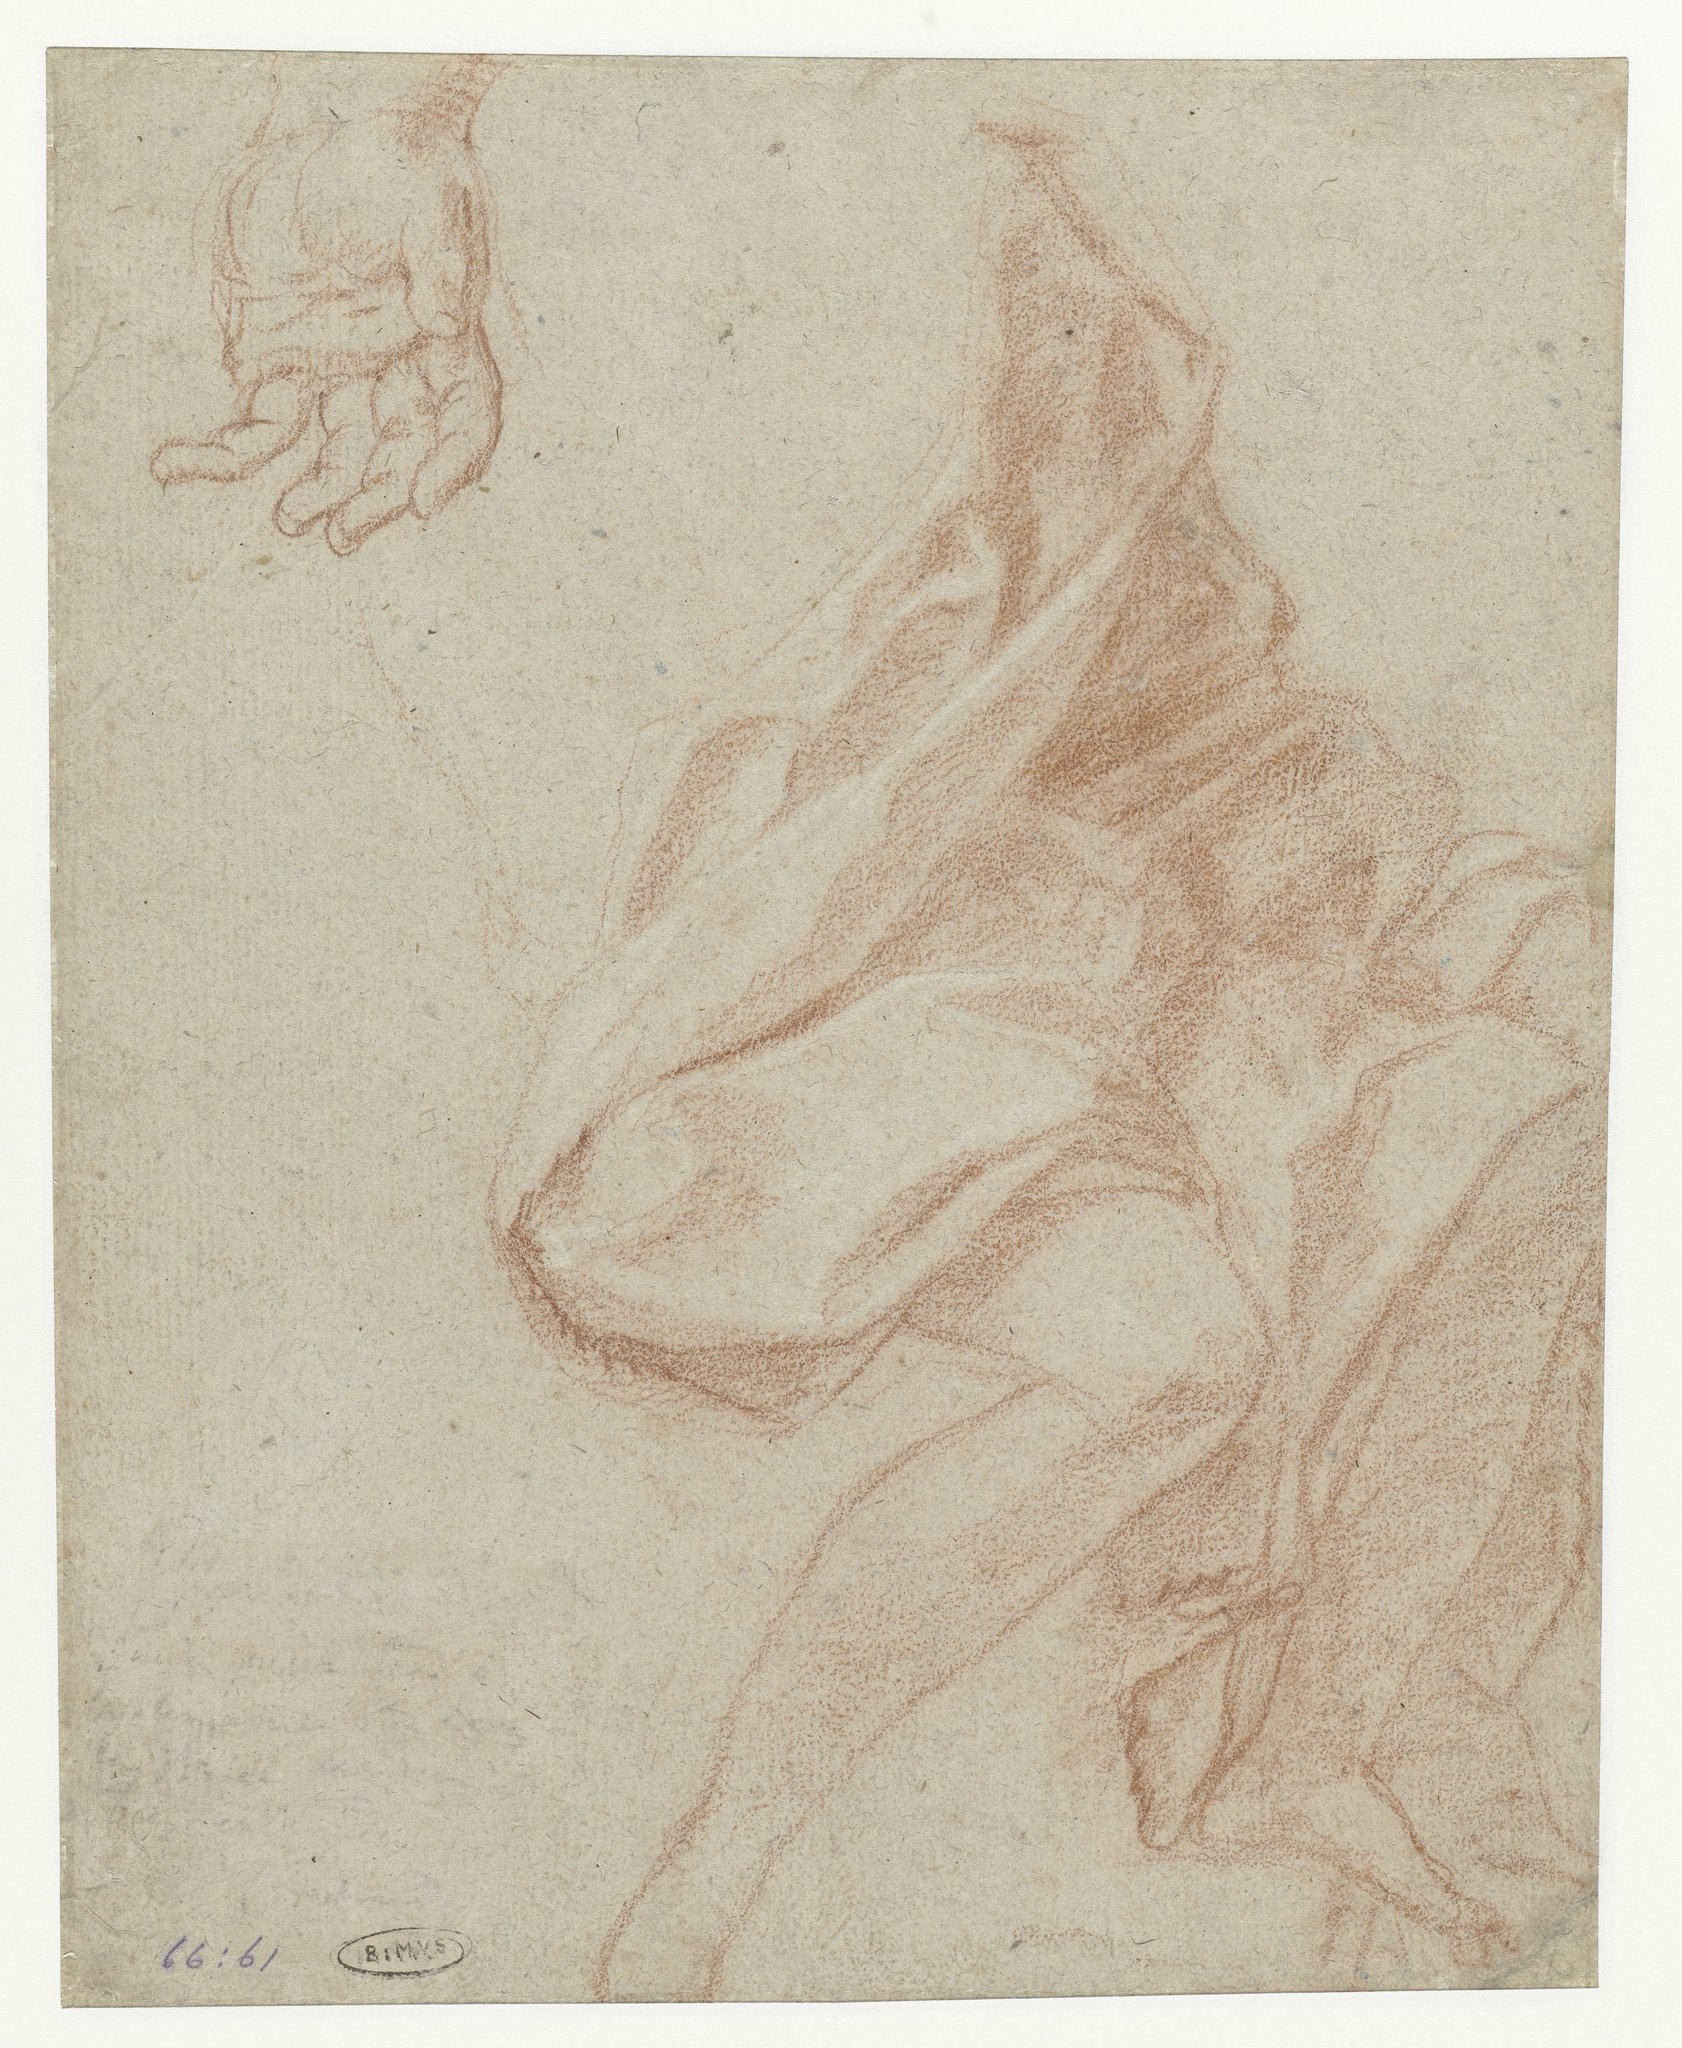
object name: drawing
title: Studies voor het onderlichaam en benen en binnenzijde van hand van Hieronymus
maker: benedetto luti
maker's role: draughtsman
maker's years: 1666-1724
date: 1676-1724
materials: chalk, paper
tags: hand, legs, the monk and hermit jerome (hieronymus); possible attributes: book, cardinal's hat, crucifix, hour-glass, lion, skull, stone, drapery, draped garment, 'gewandgebung'